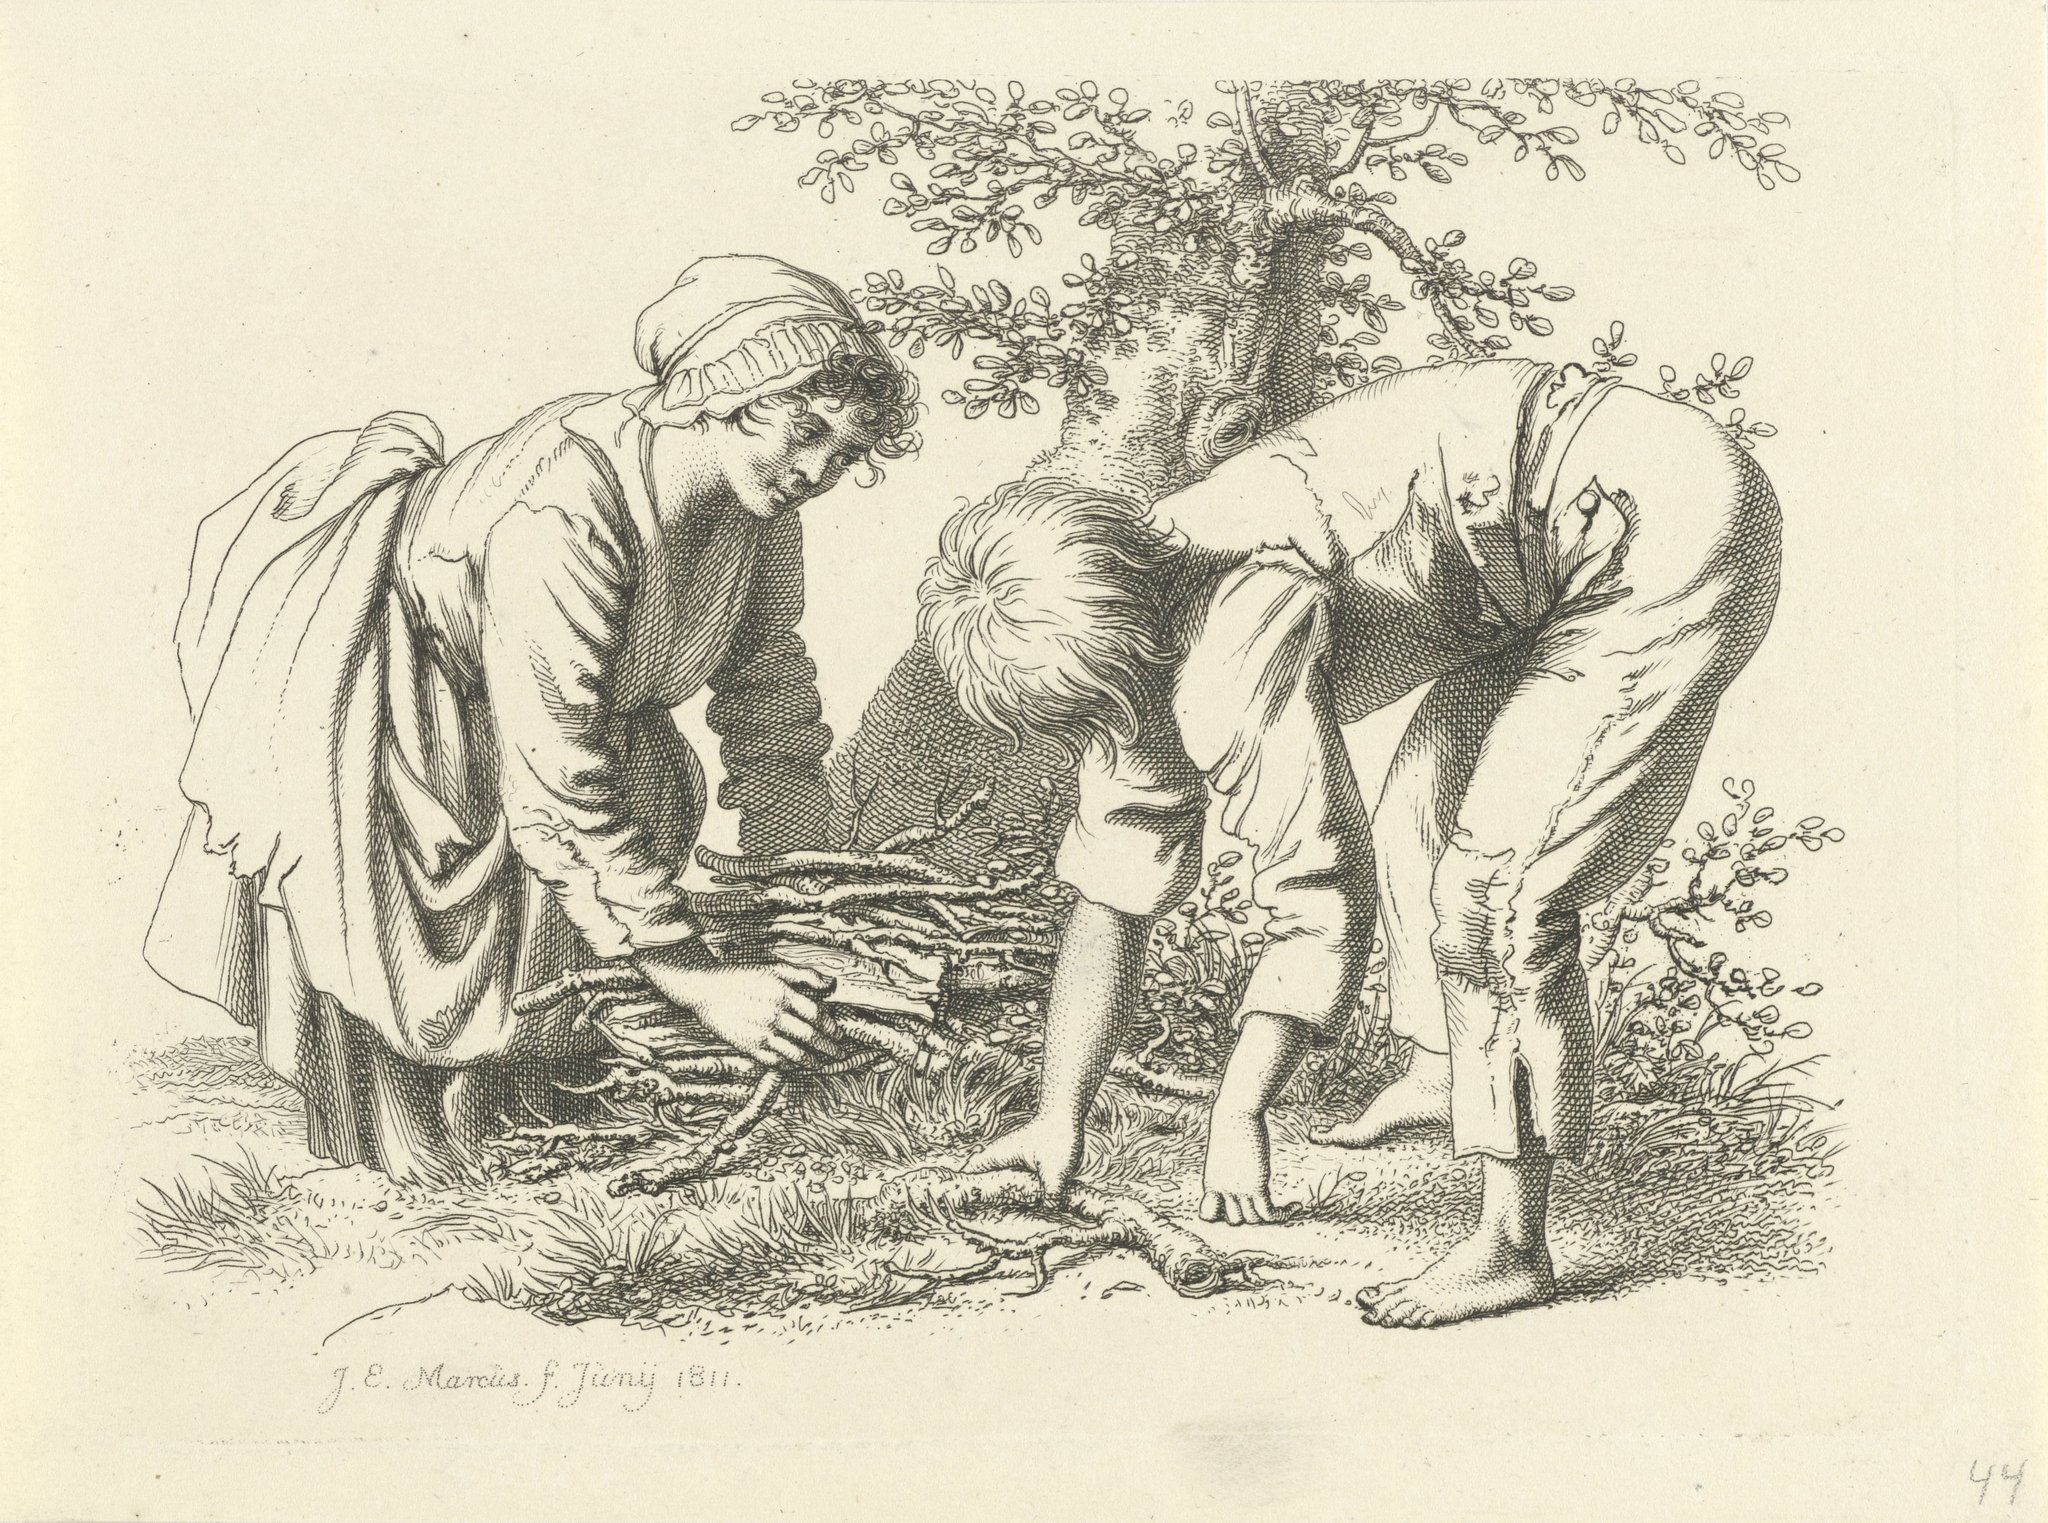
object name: print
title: Studie-prentwerk / Etudes gravées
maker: jacob ernst marcus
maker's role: draughtsman, print maker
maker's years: 1774-1826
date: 1806-1811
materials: paper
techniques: etching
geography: amsterdam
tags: woodgathering, woodgatherer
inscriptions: collector's mark: Lugt 2228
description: Serie voor het eerst uitgegeven door Jacob Ernst Marcus onder de titel Studiebeelden en Fragmenten. Amsterdam: ca.1816. Later heruitgegeven als: Studie-prentwerk/ Etudes gravées.